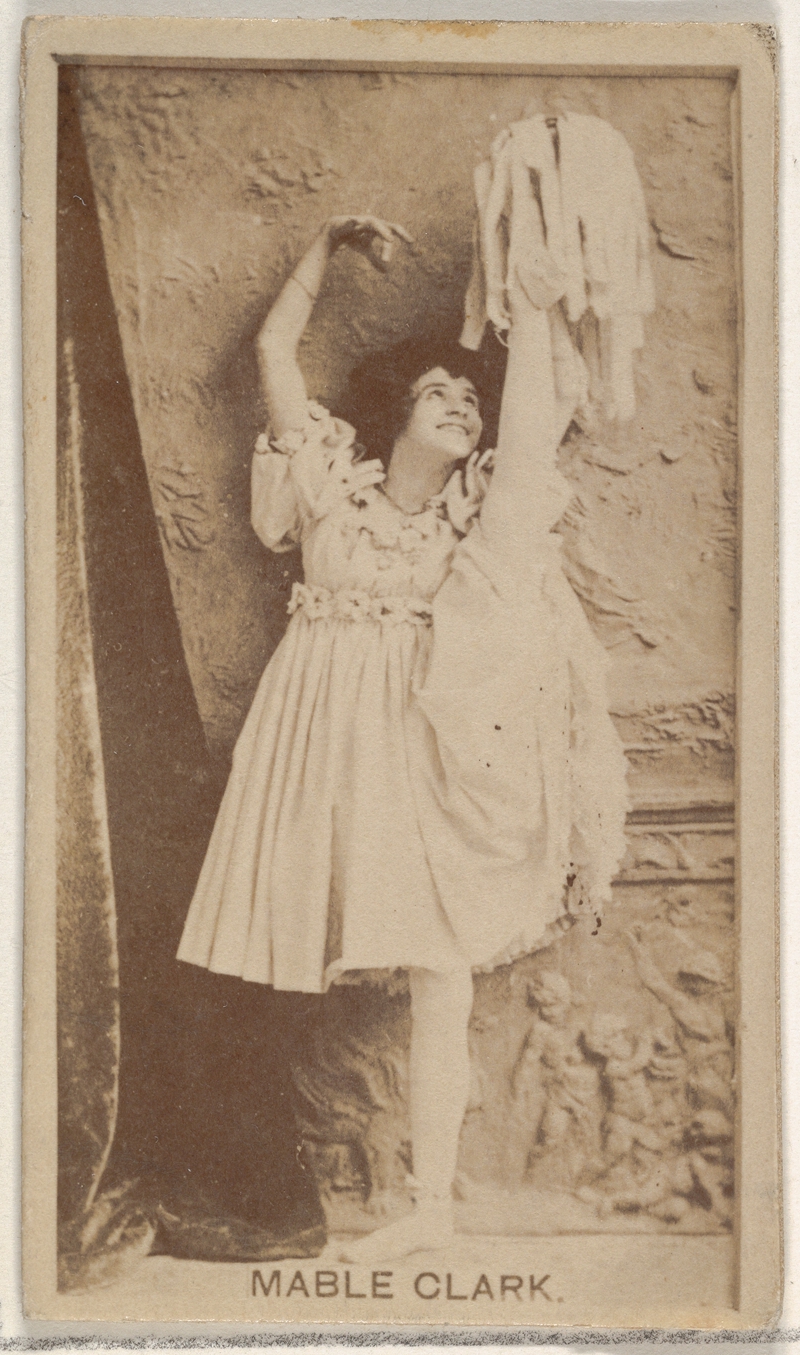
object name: photograph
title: Mabel Clark, from the Actors and Actresses series (N45, Type 8) for Virginia Brights Cigarettes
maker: allen & ginter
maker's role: publisher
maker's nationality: american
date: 1888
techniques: albumen silver print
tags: portraits,women,actresses